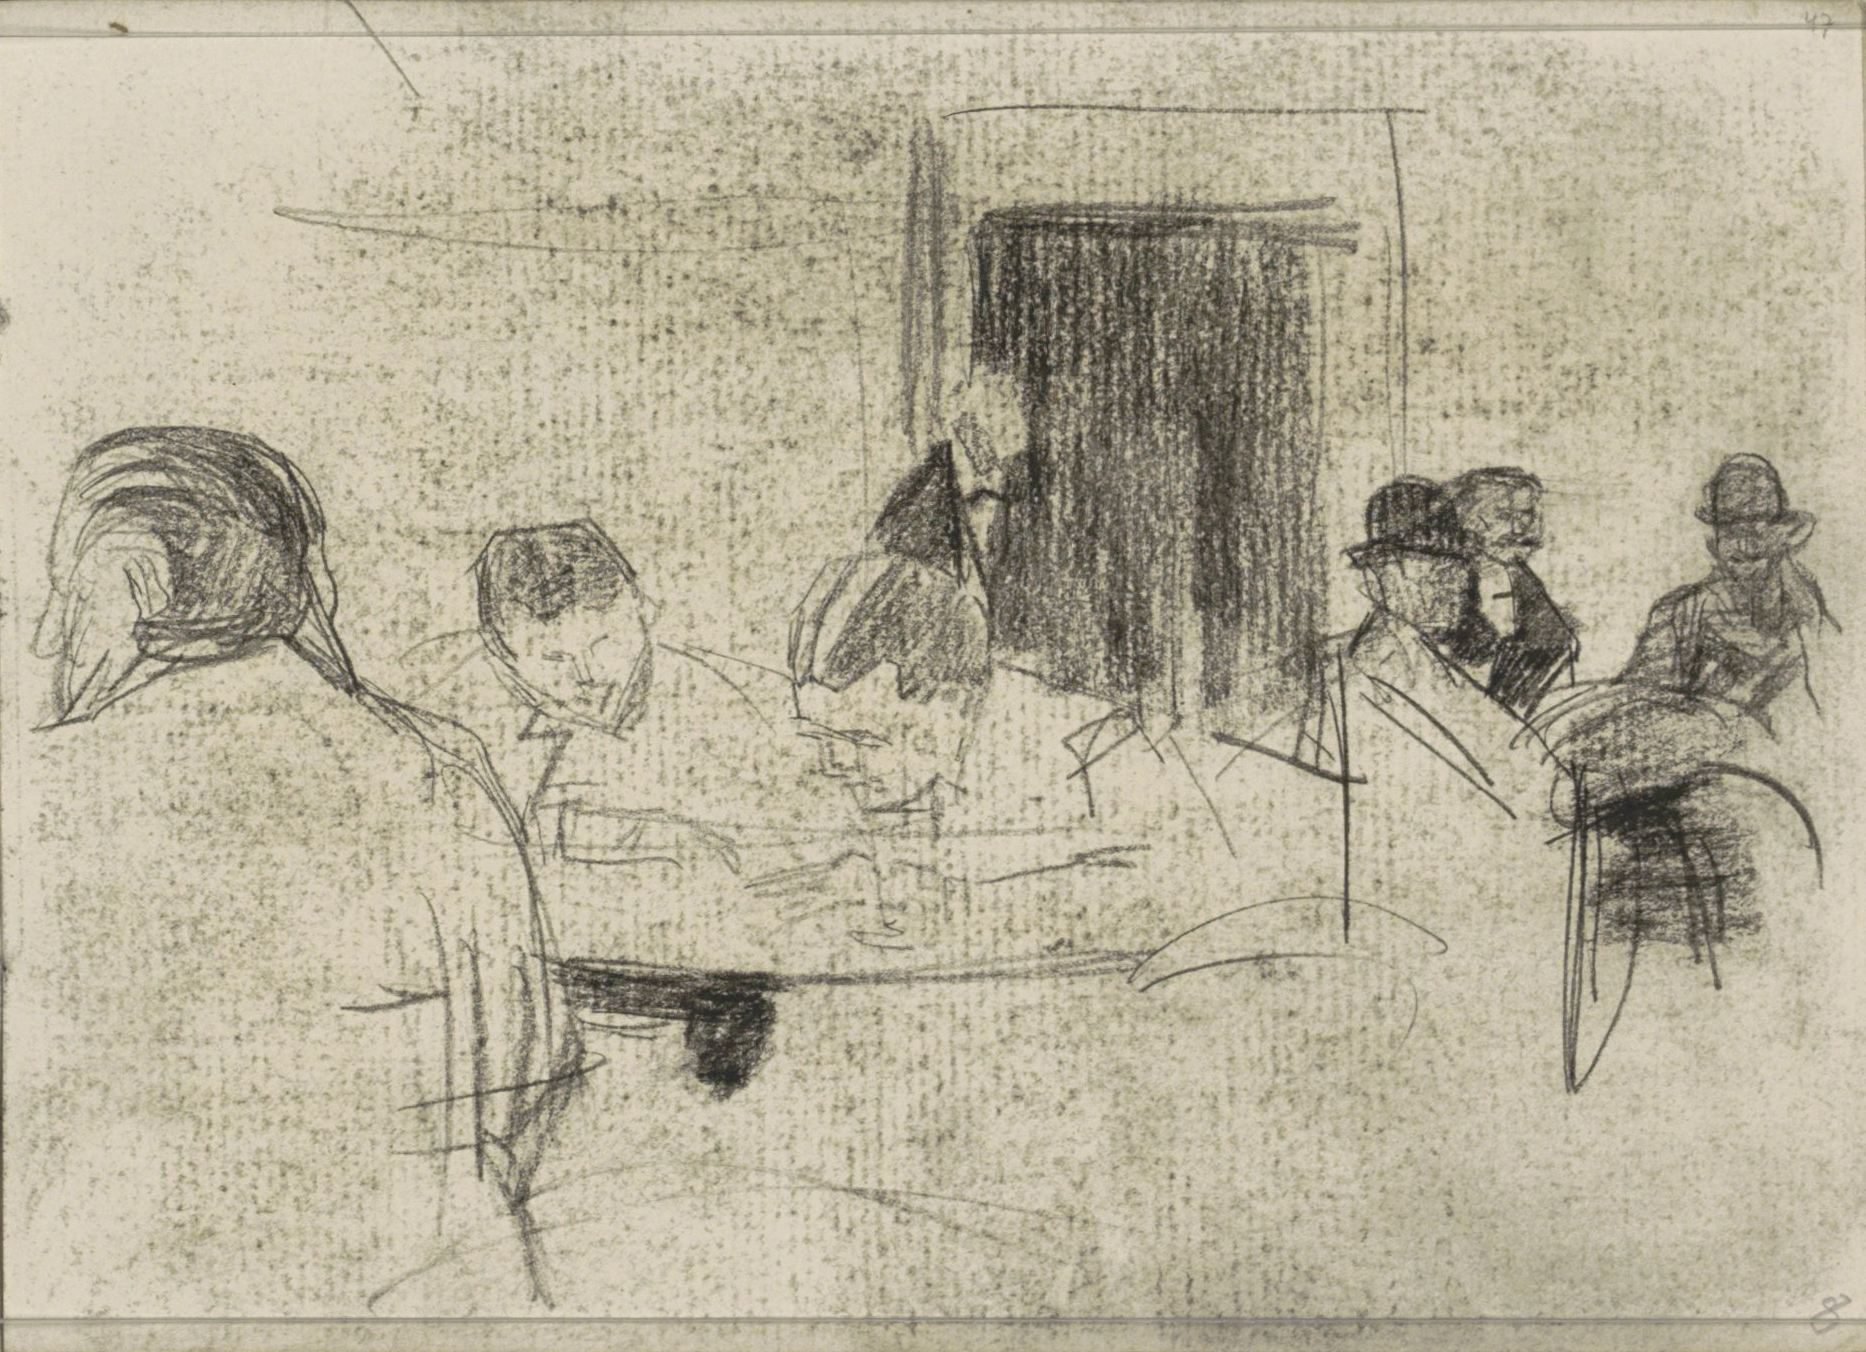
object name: sketchbook leaf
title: Mannen aan tafels, mogelijk in een café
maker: isaac israels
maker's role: draughtsman, painter, print maker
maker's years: 1865-1934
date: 1875-1934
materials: chalk, paper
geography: amsterdam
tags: adult man (+ sitting), inn, coffee-house, public house, etc.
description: Blad 8 recto uit schetsboek XXXI met 10 bladen.